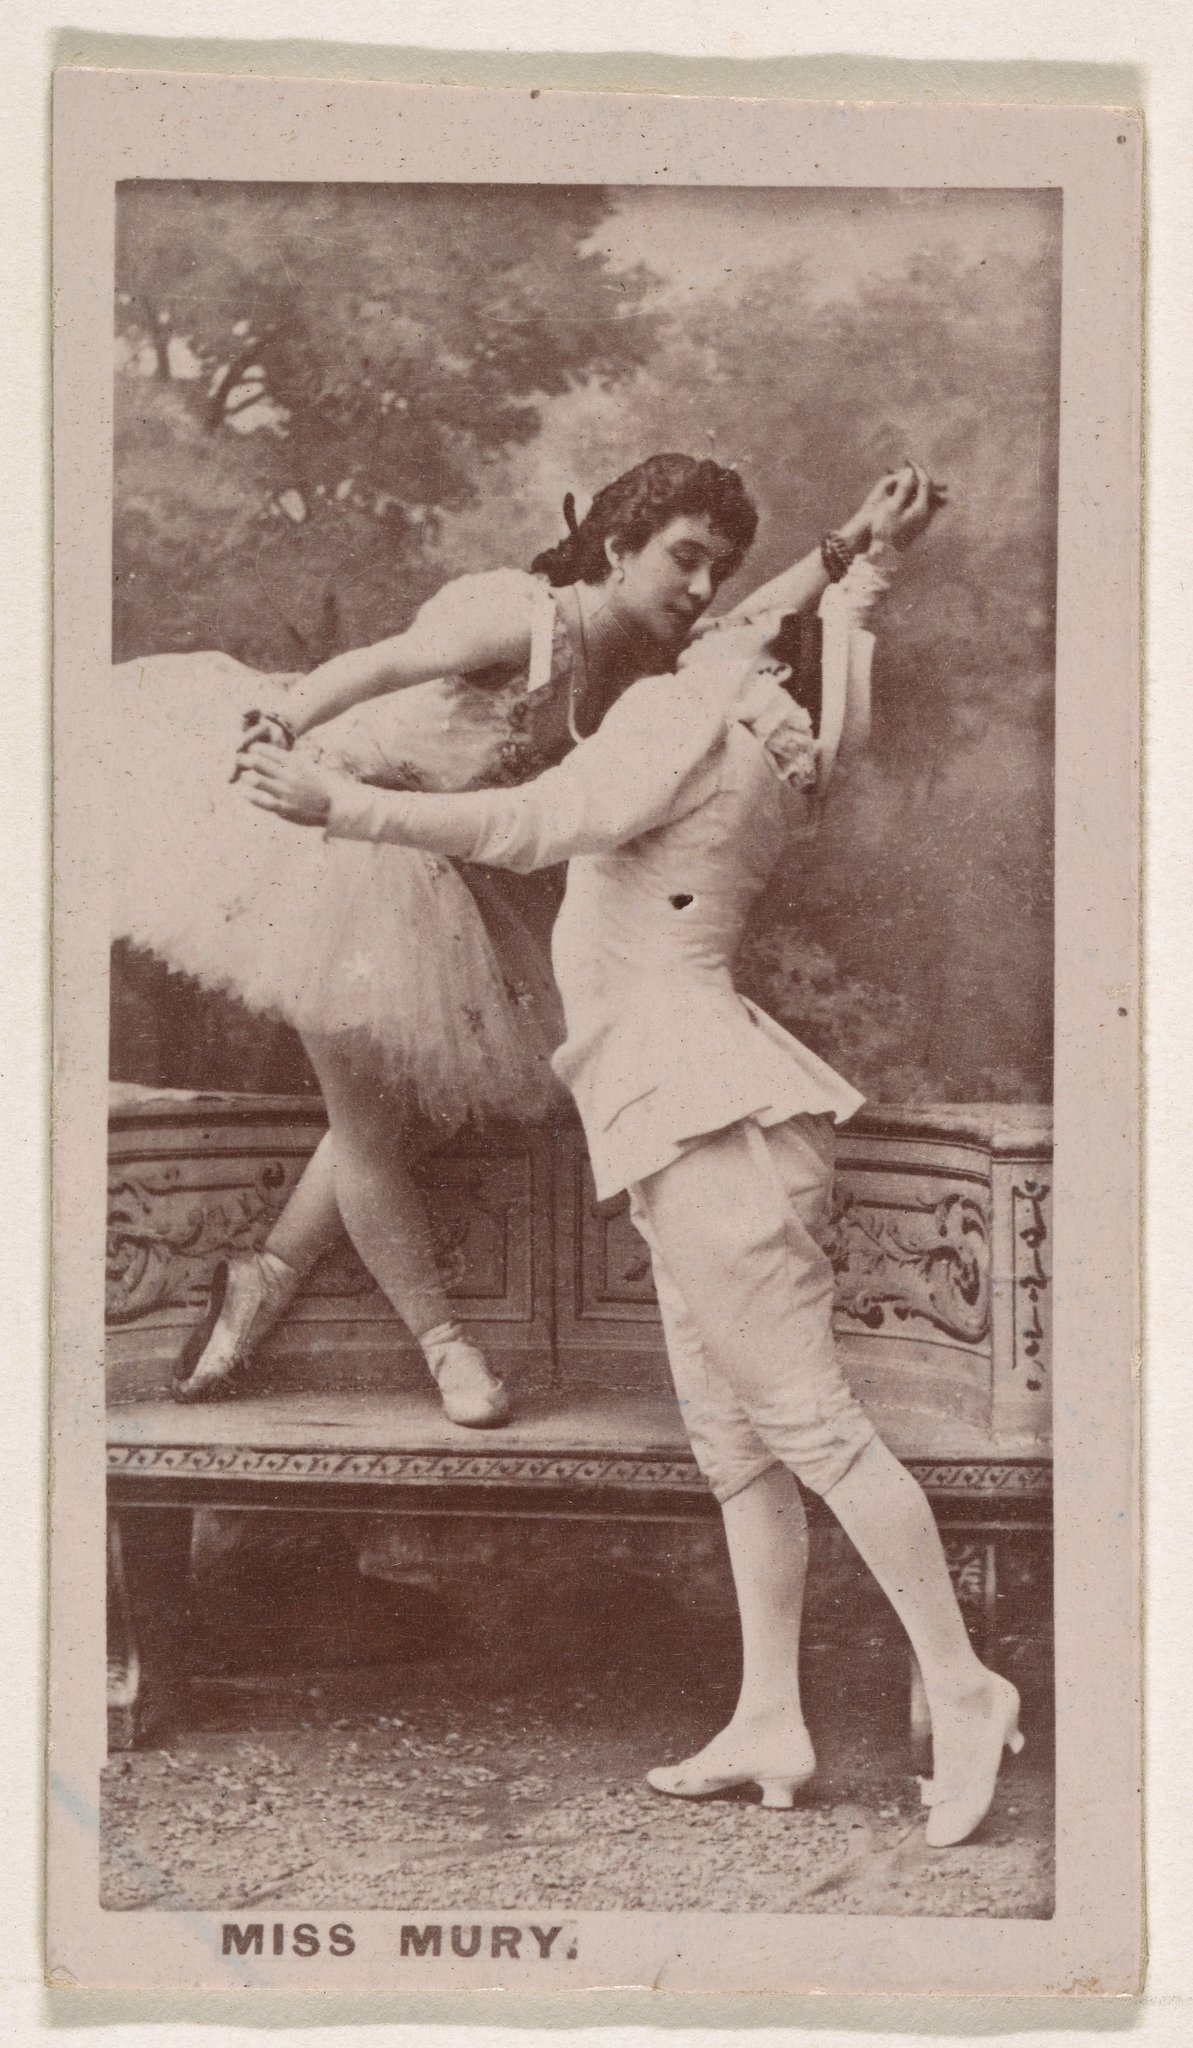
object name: photograph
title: Miss Mury, from the Actresses series (N245) issued by Kinney Brothers to promote Sweet Caporal Cigarettes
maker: kinney brothers tobacco company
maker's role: publisher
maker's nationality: american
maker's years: 1869-2011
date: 1890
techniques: albumen silver print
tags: women,actresses